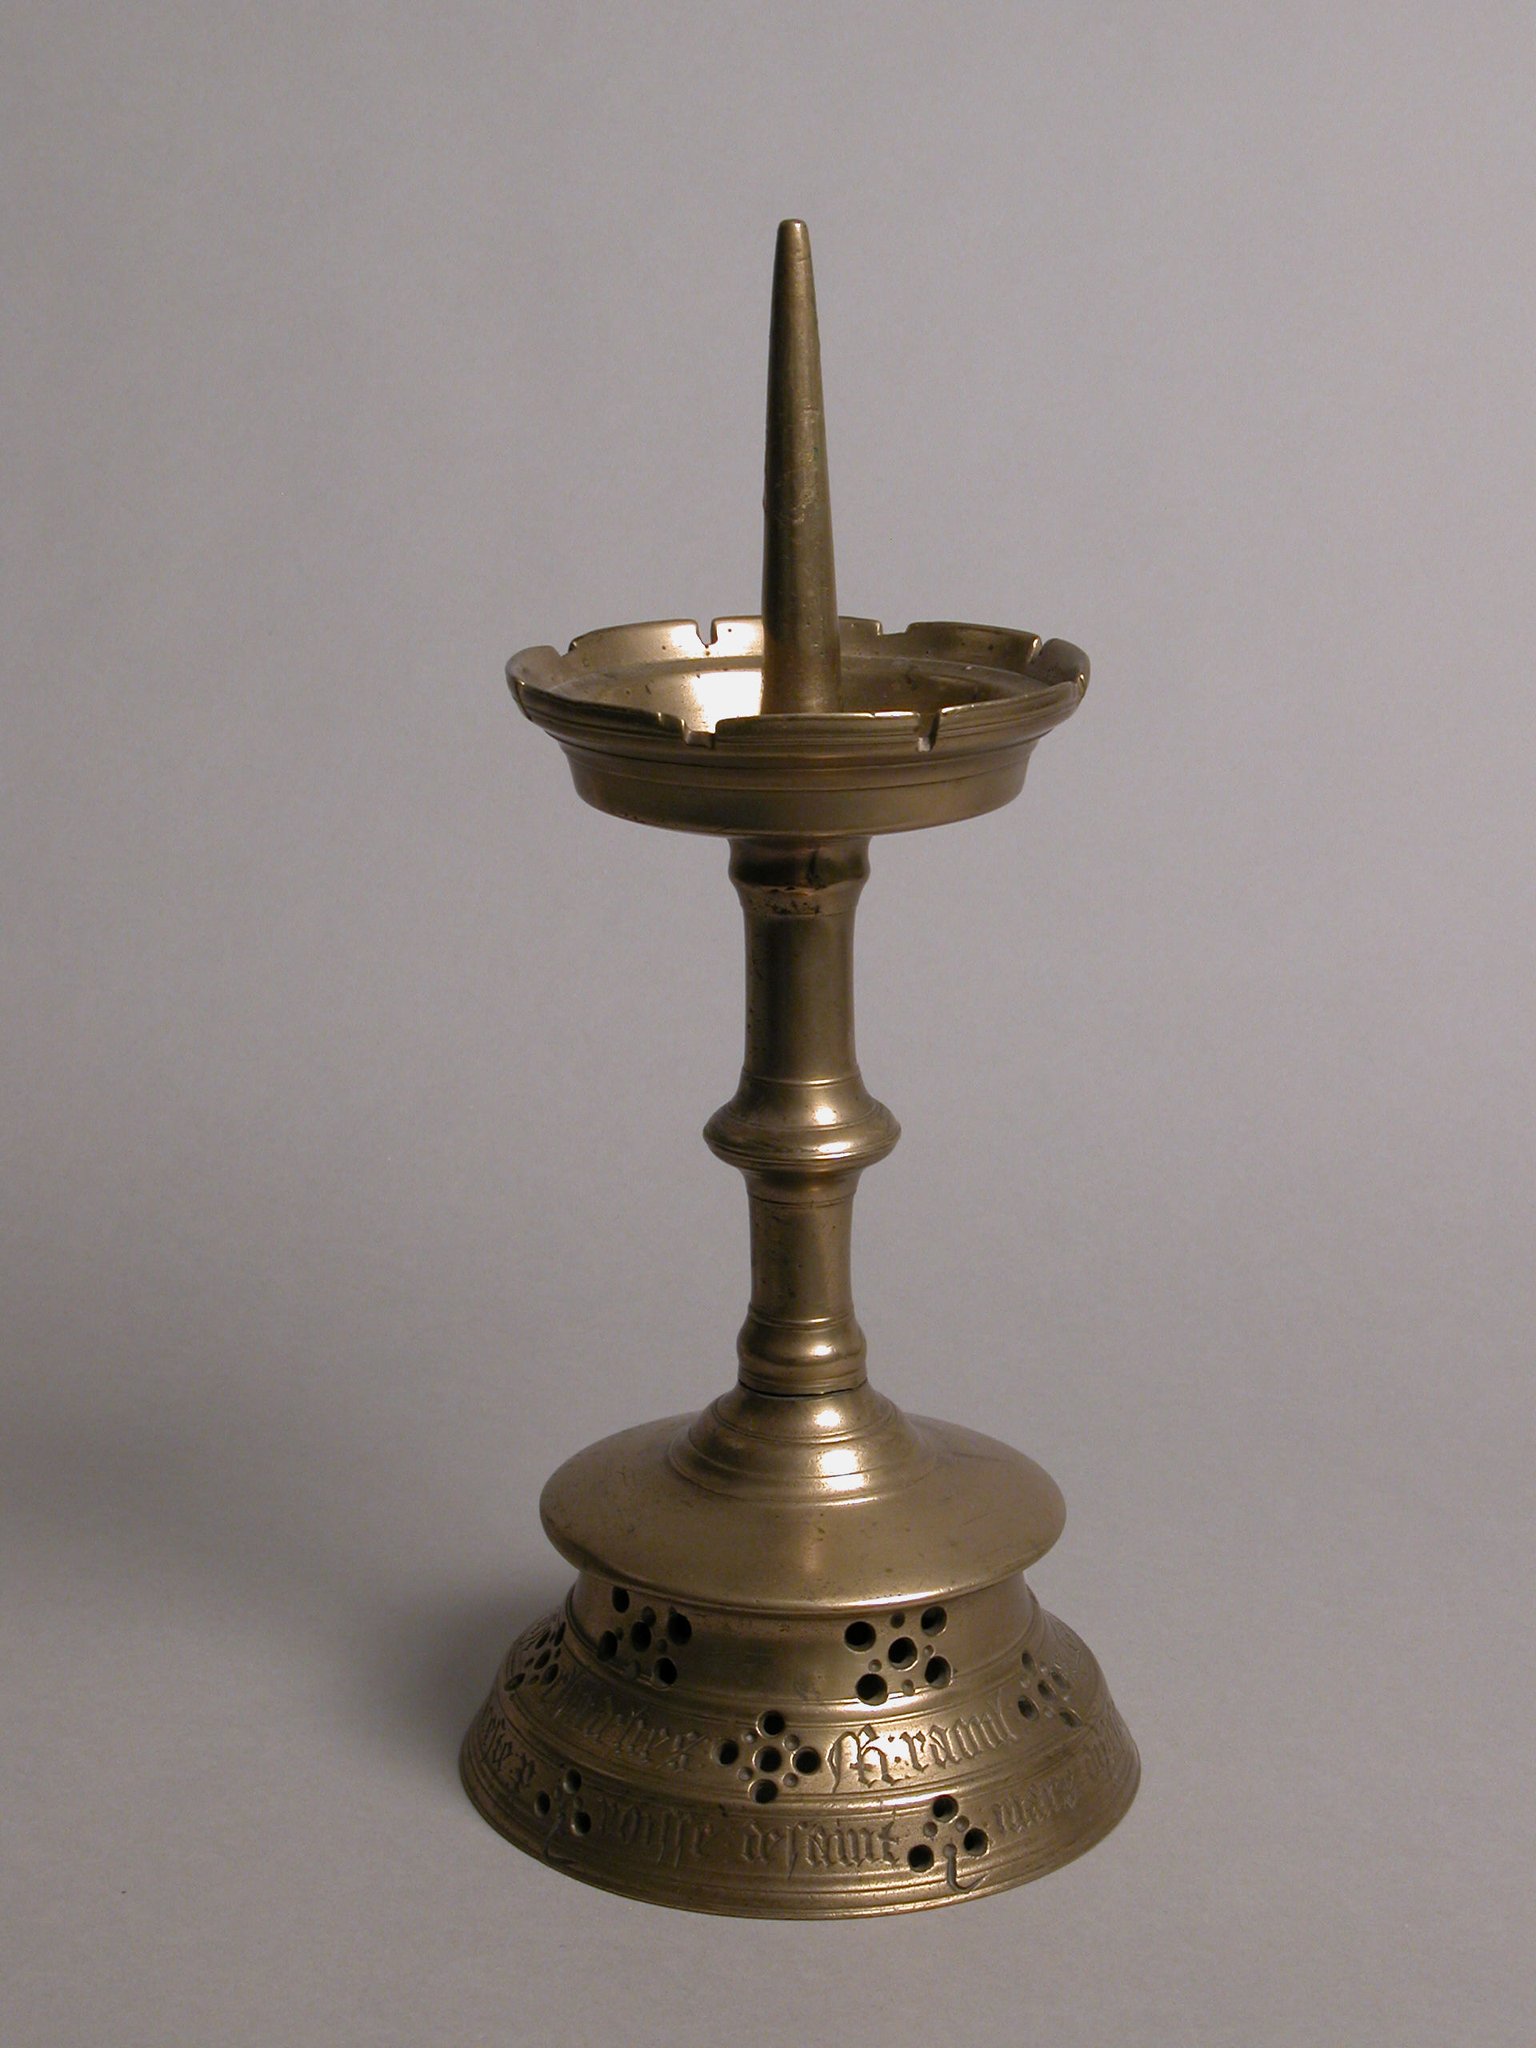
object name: candlestick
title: Pricket Candlestick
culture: french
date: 1445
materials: brass